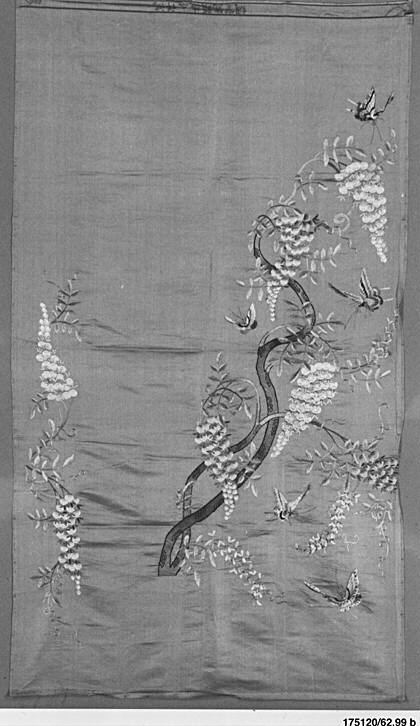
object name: length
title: Lengths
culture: chinese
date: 1801-2000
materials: metal thread, silk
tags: butterflies,plants